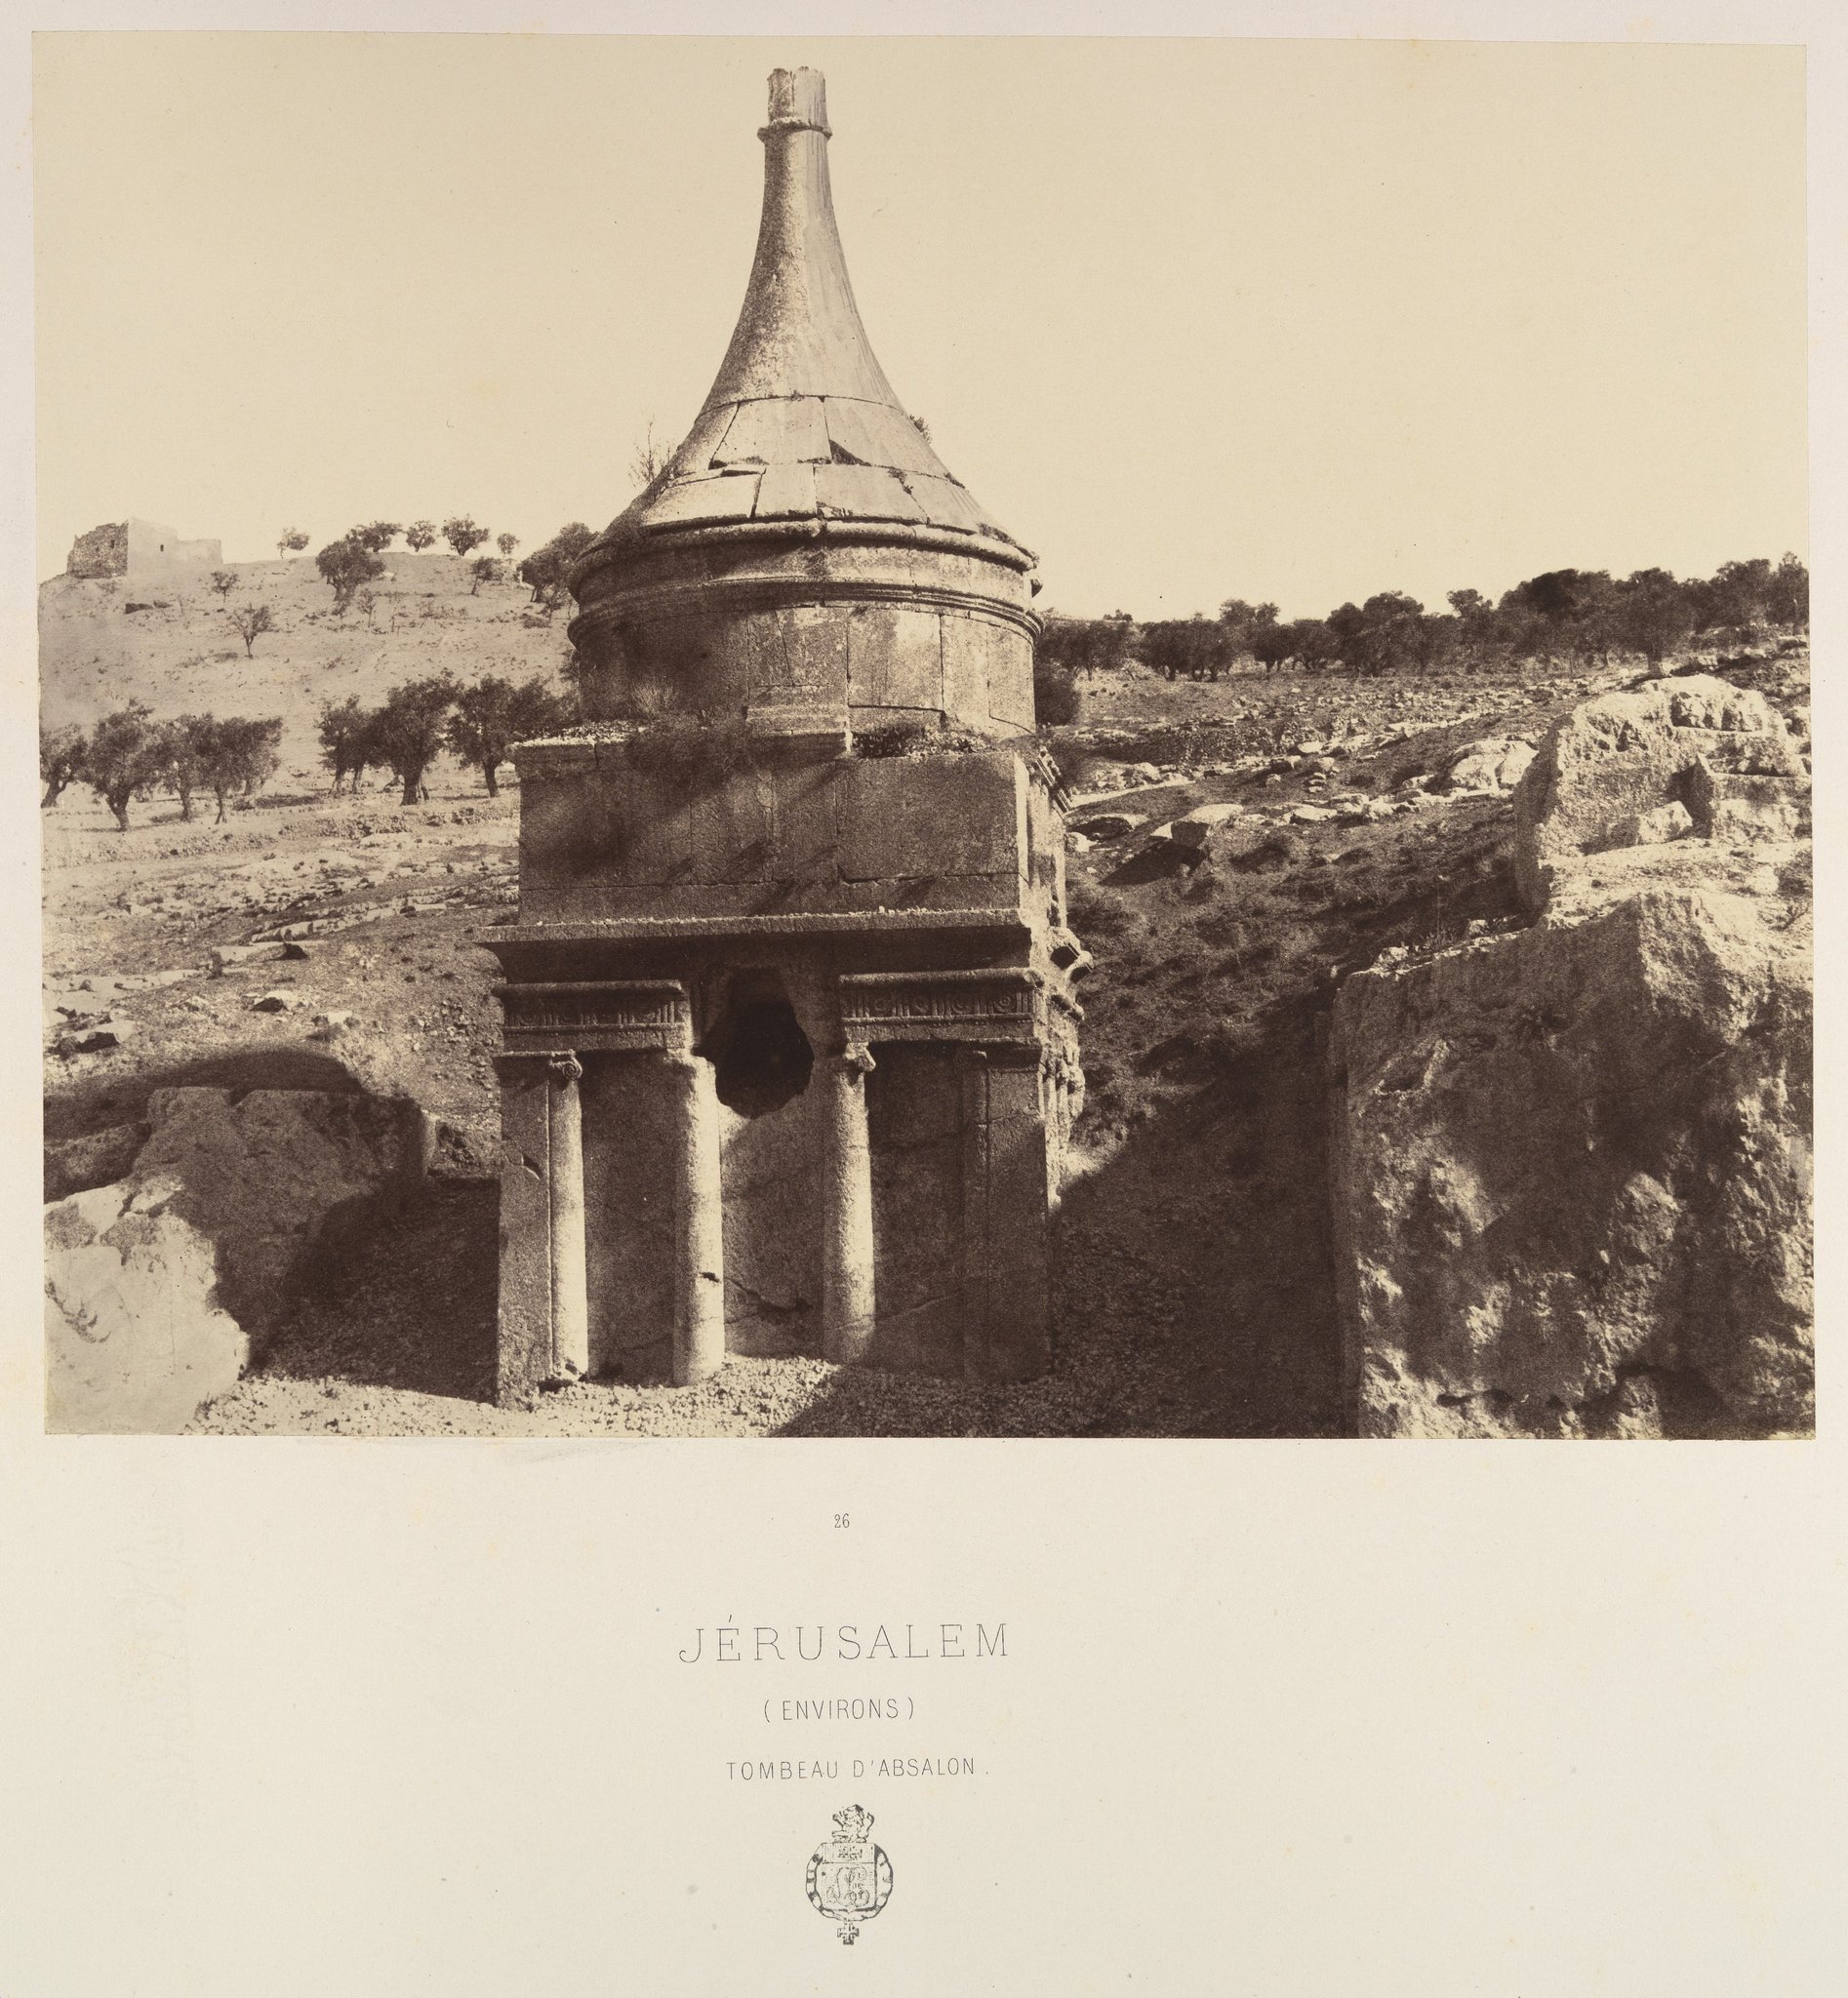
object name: photograph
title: Jérusalem. (Environs) Tombeau d'Absalon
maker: louis de clercq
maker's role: artist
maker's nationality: french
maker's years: 1837-1901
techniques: albumen silver print, paper negative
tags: architecture,tombs